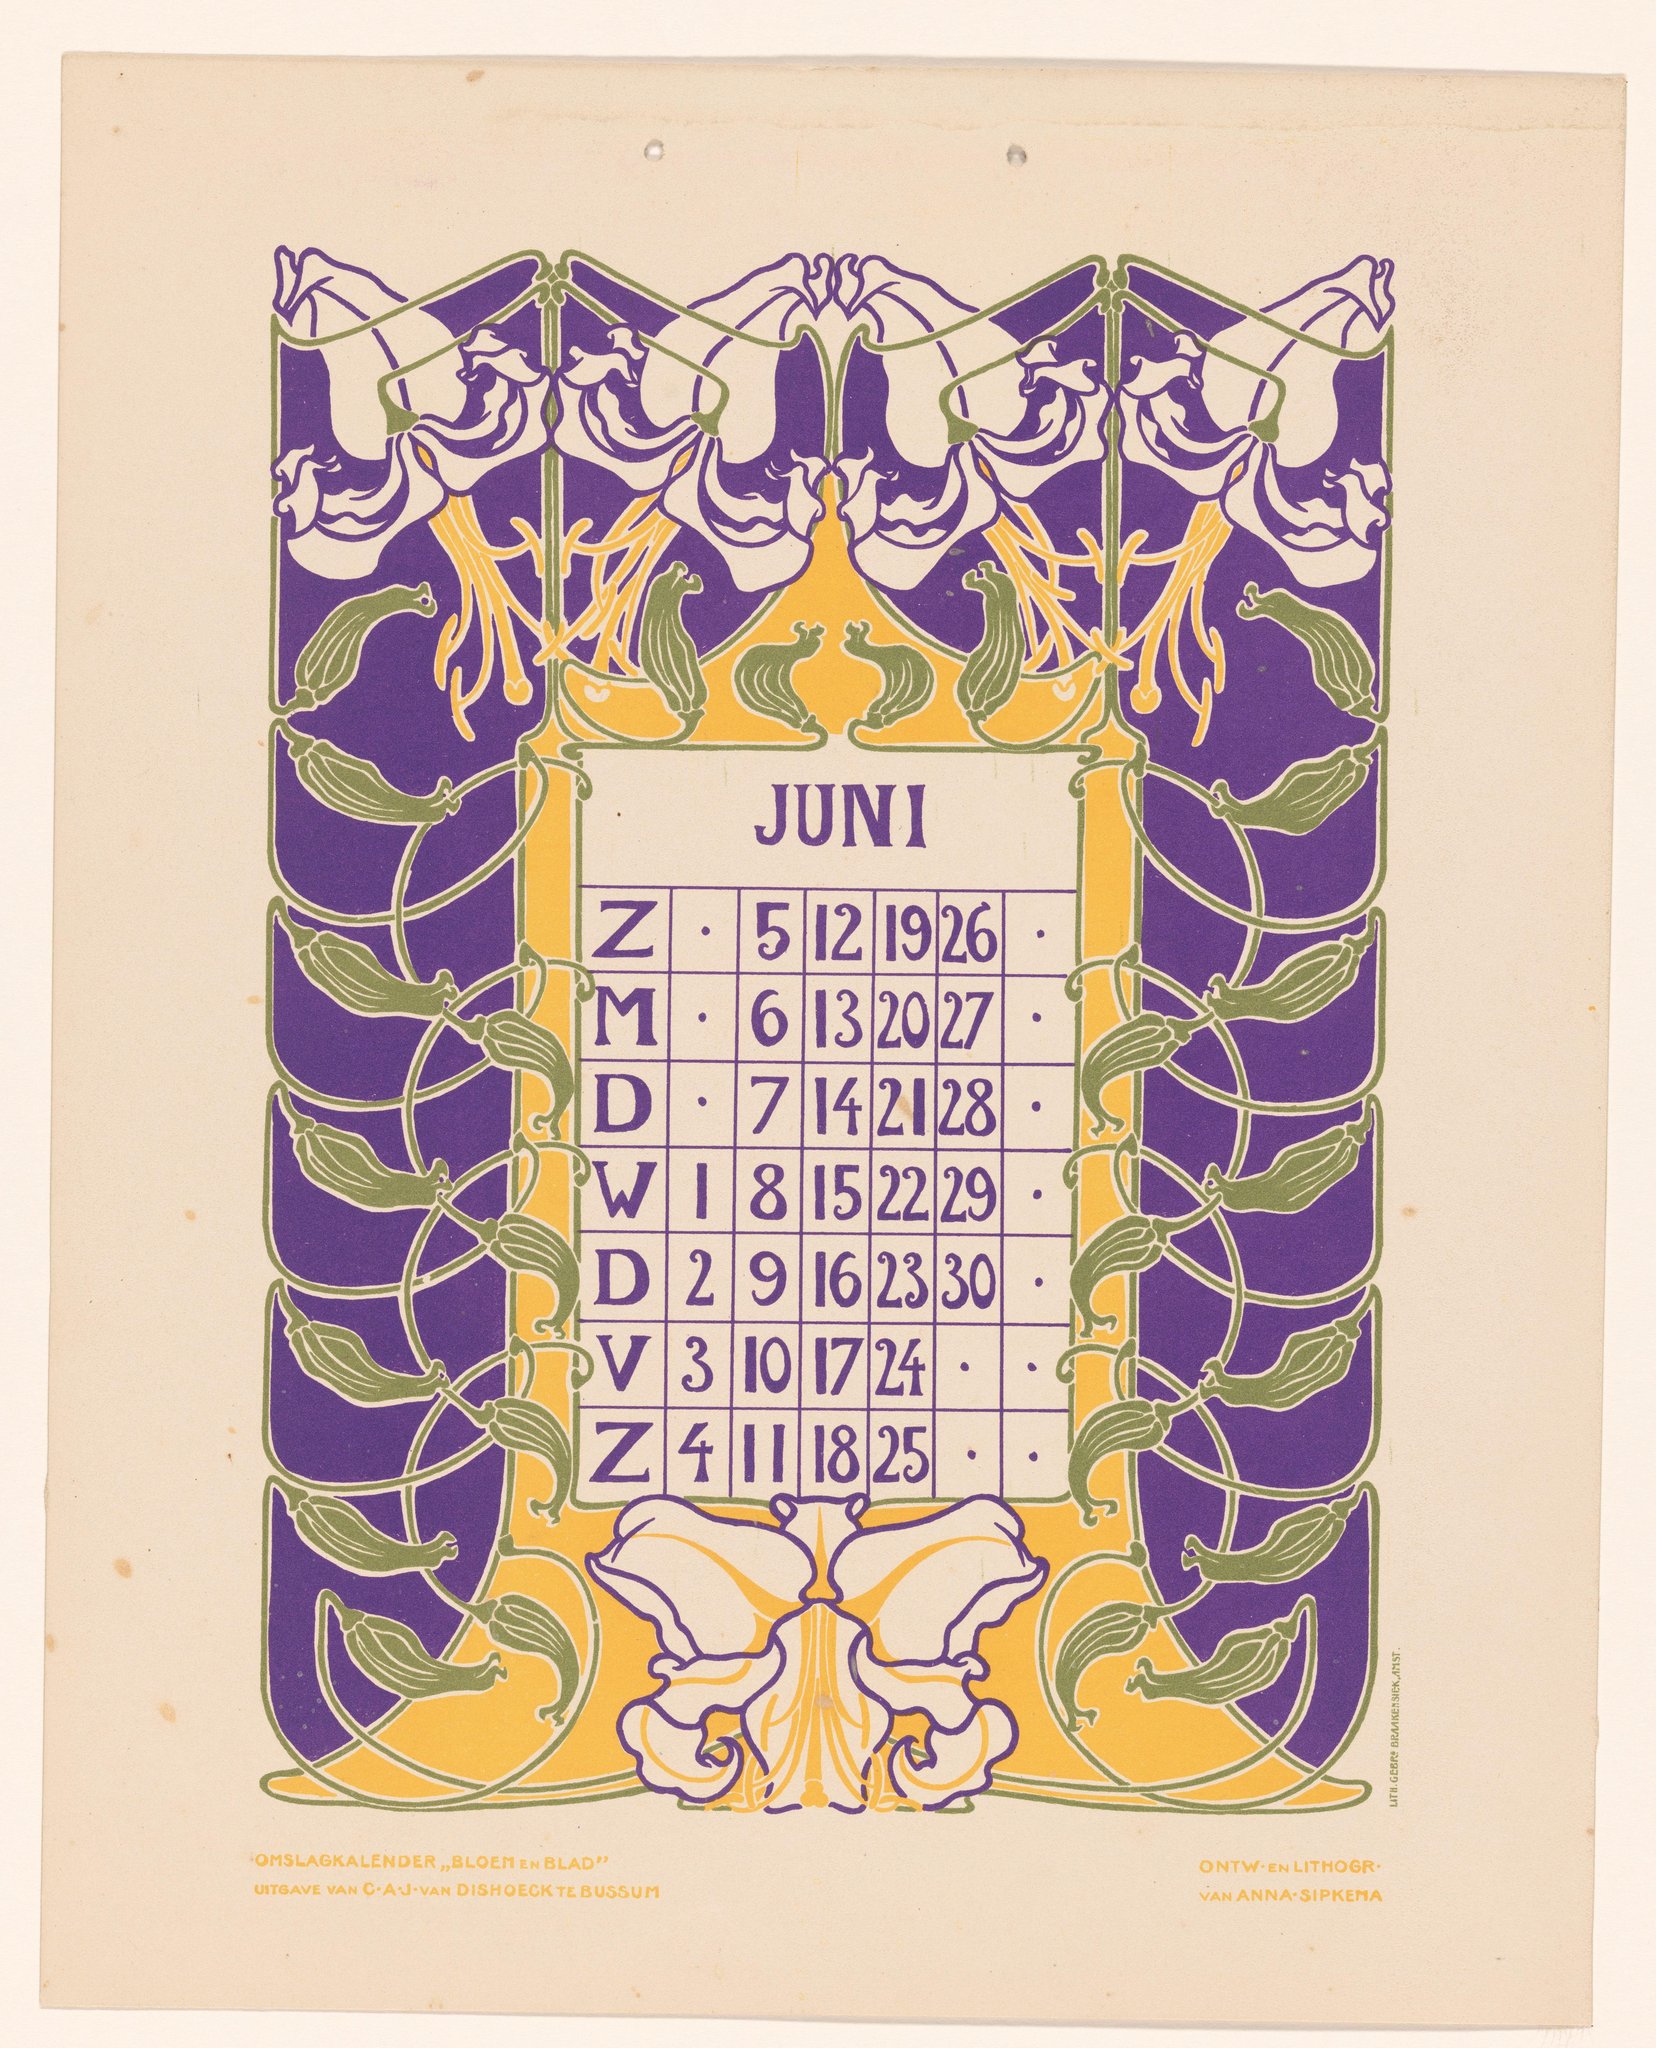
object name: print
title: Kalenderblad juni met orchideeën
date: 1904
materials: paper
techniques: lithograph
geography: bussum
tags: flowers: orchid, june ~ other concepts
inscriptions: collector's mark: Lugt 2228